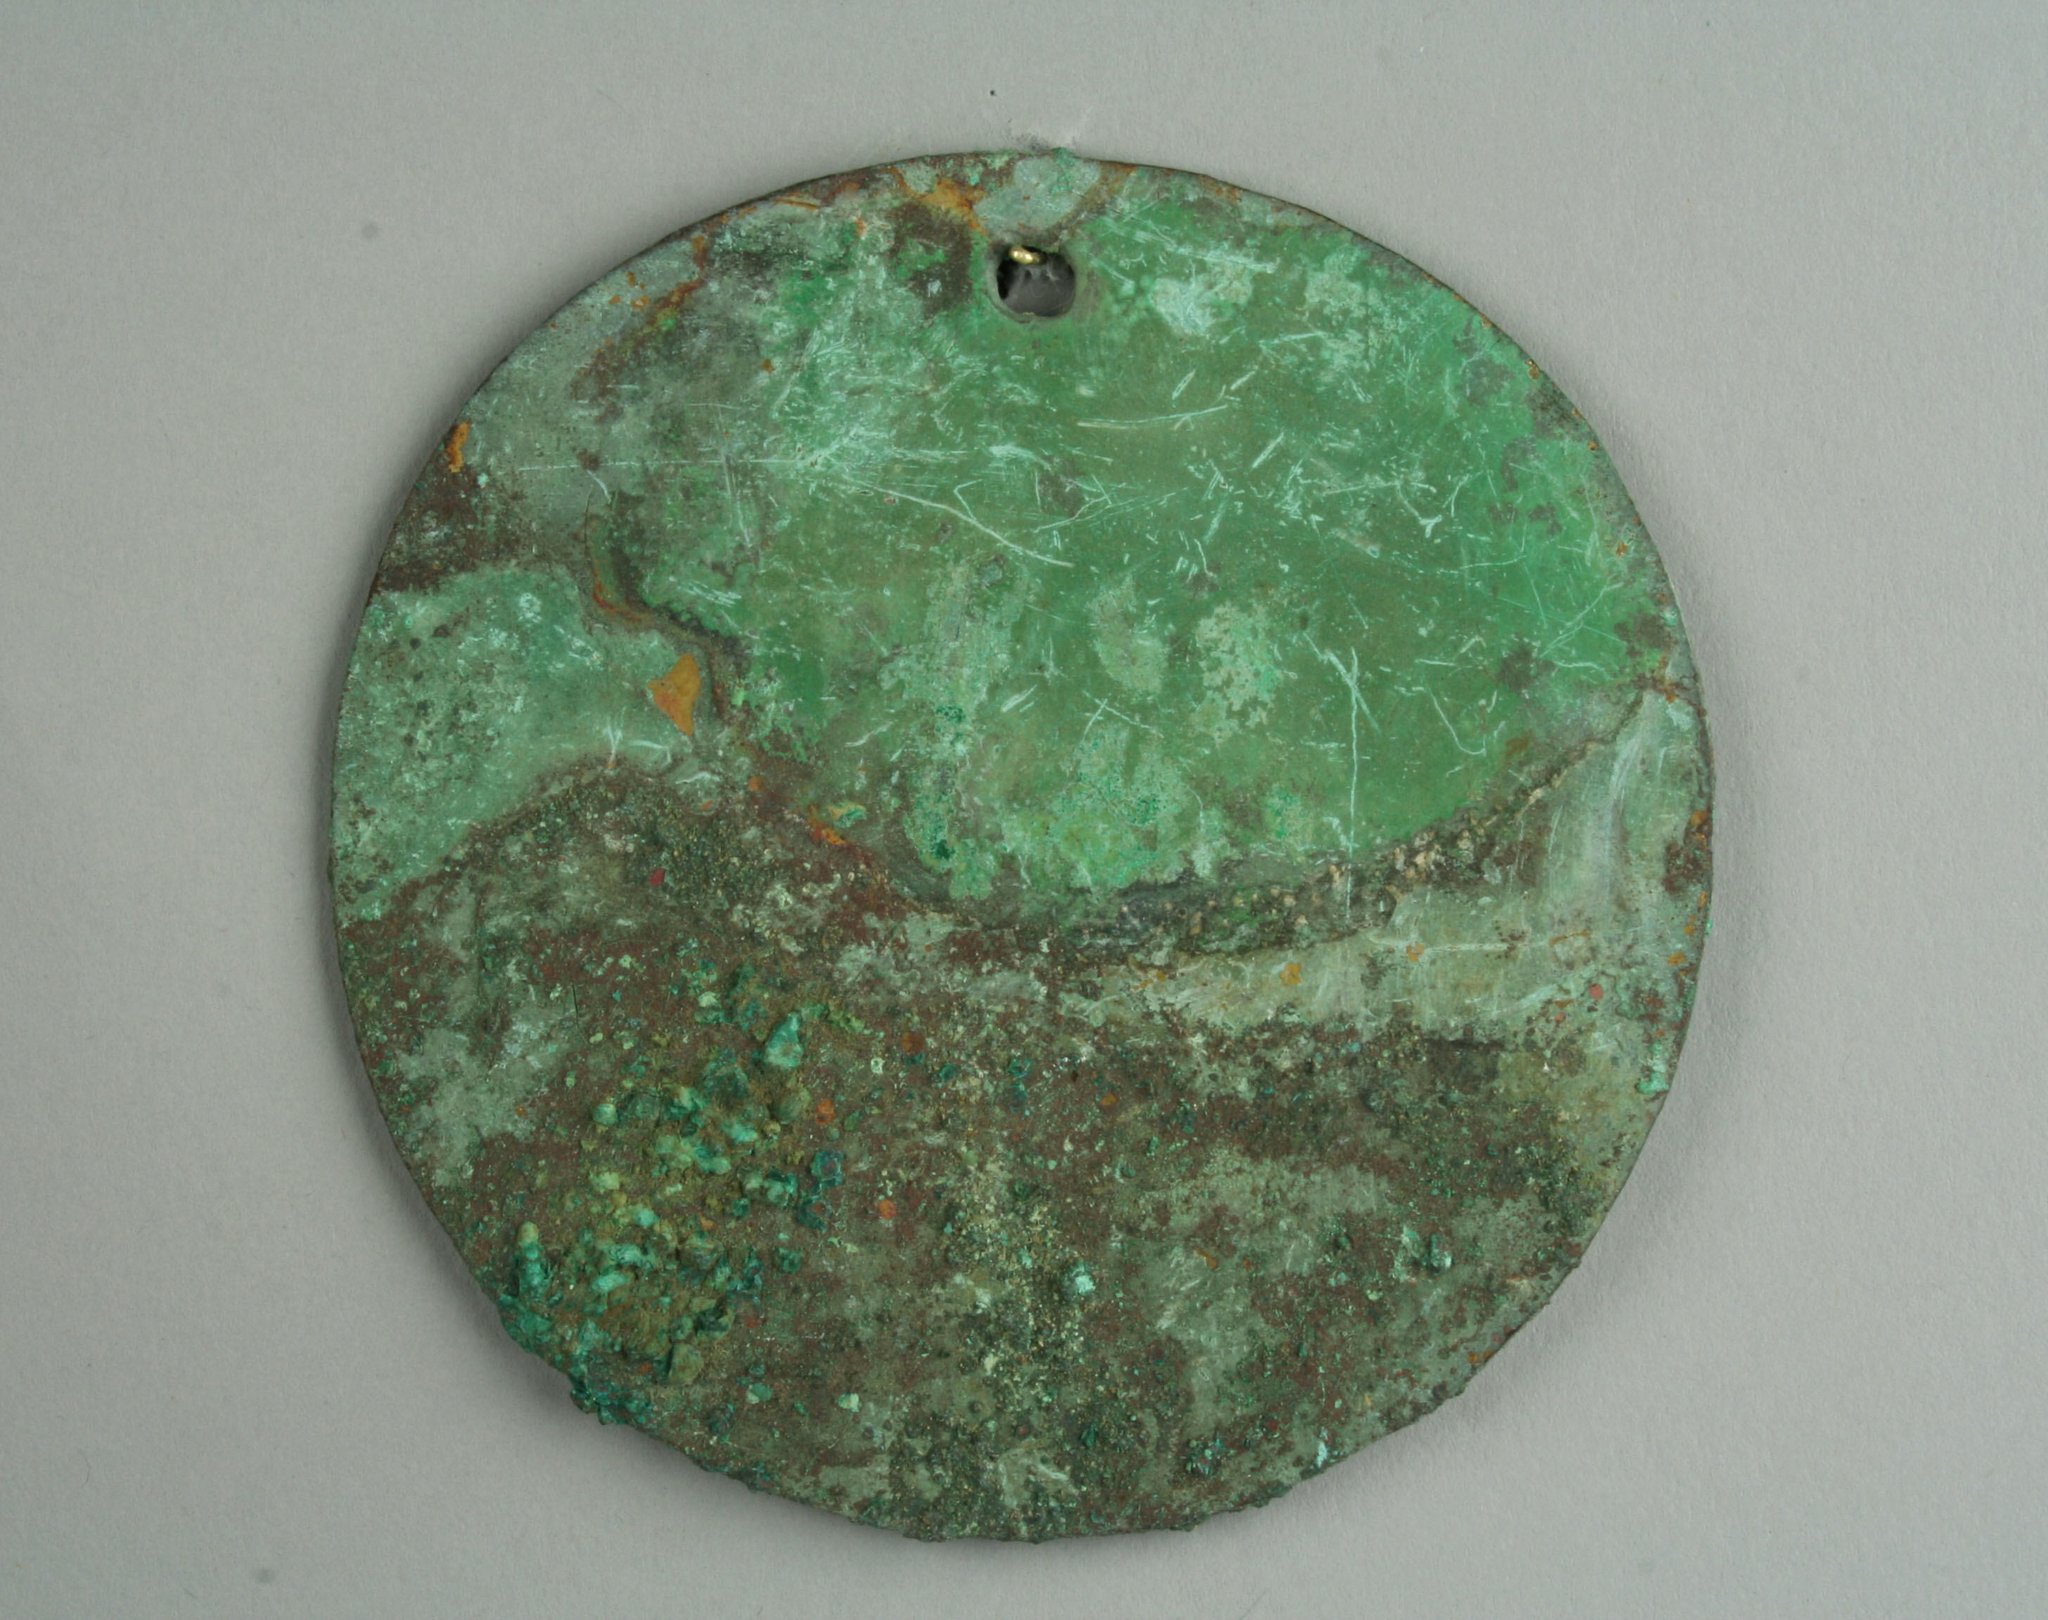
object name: plaque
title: Round Plaque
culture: vicús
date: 300 BCE-200 CE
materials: copper, gilt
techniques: hammering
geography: peru